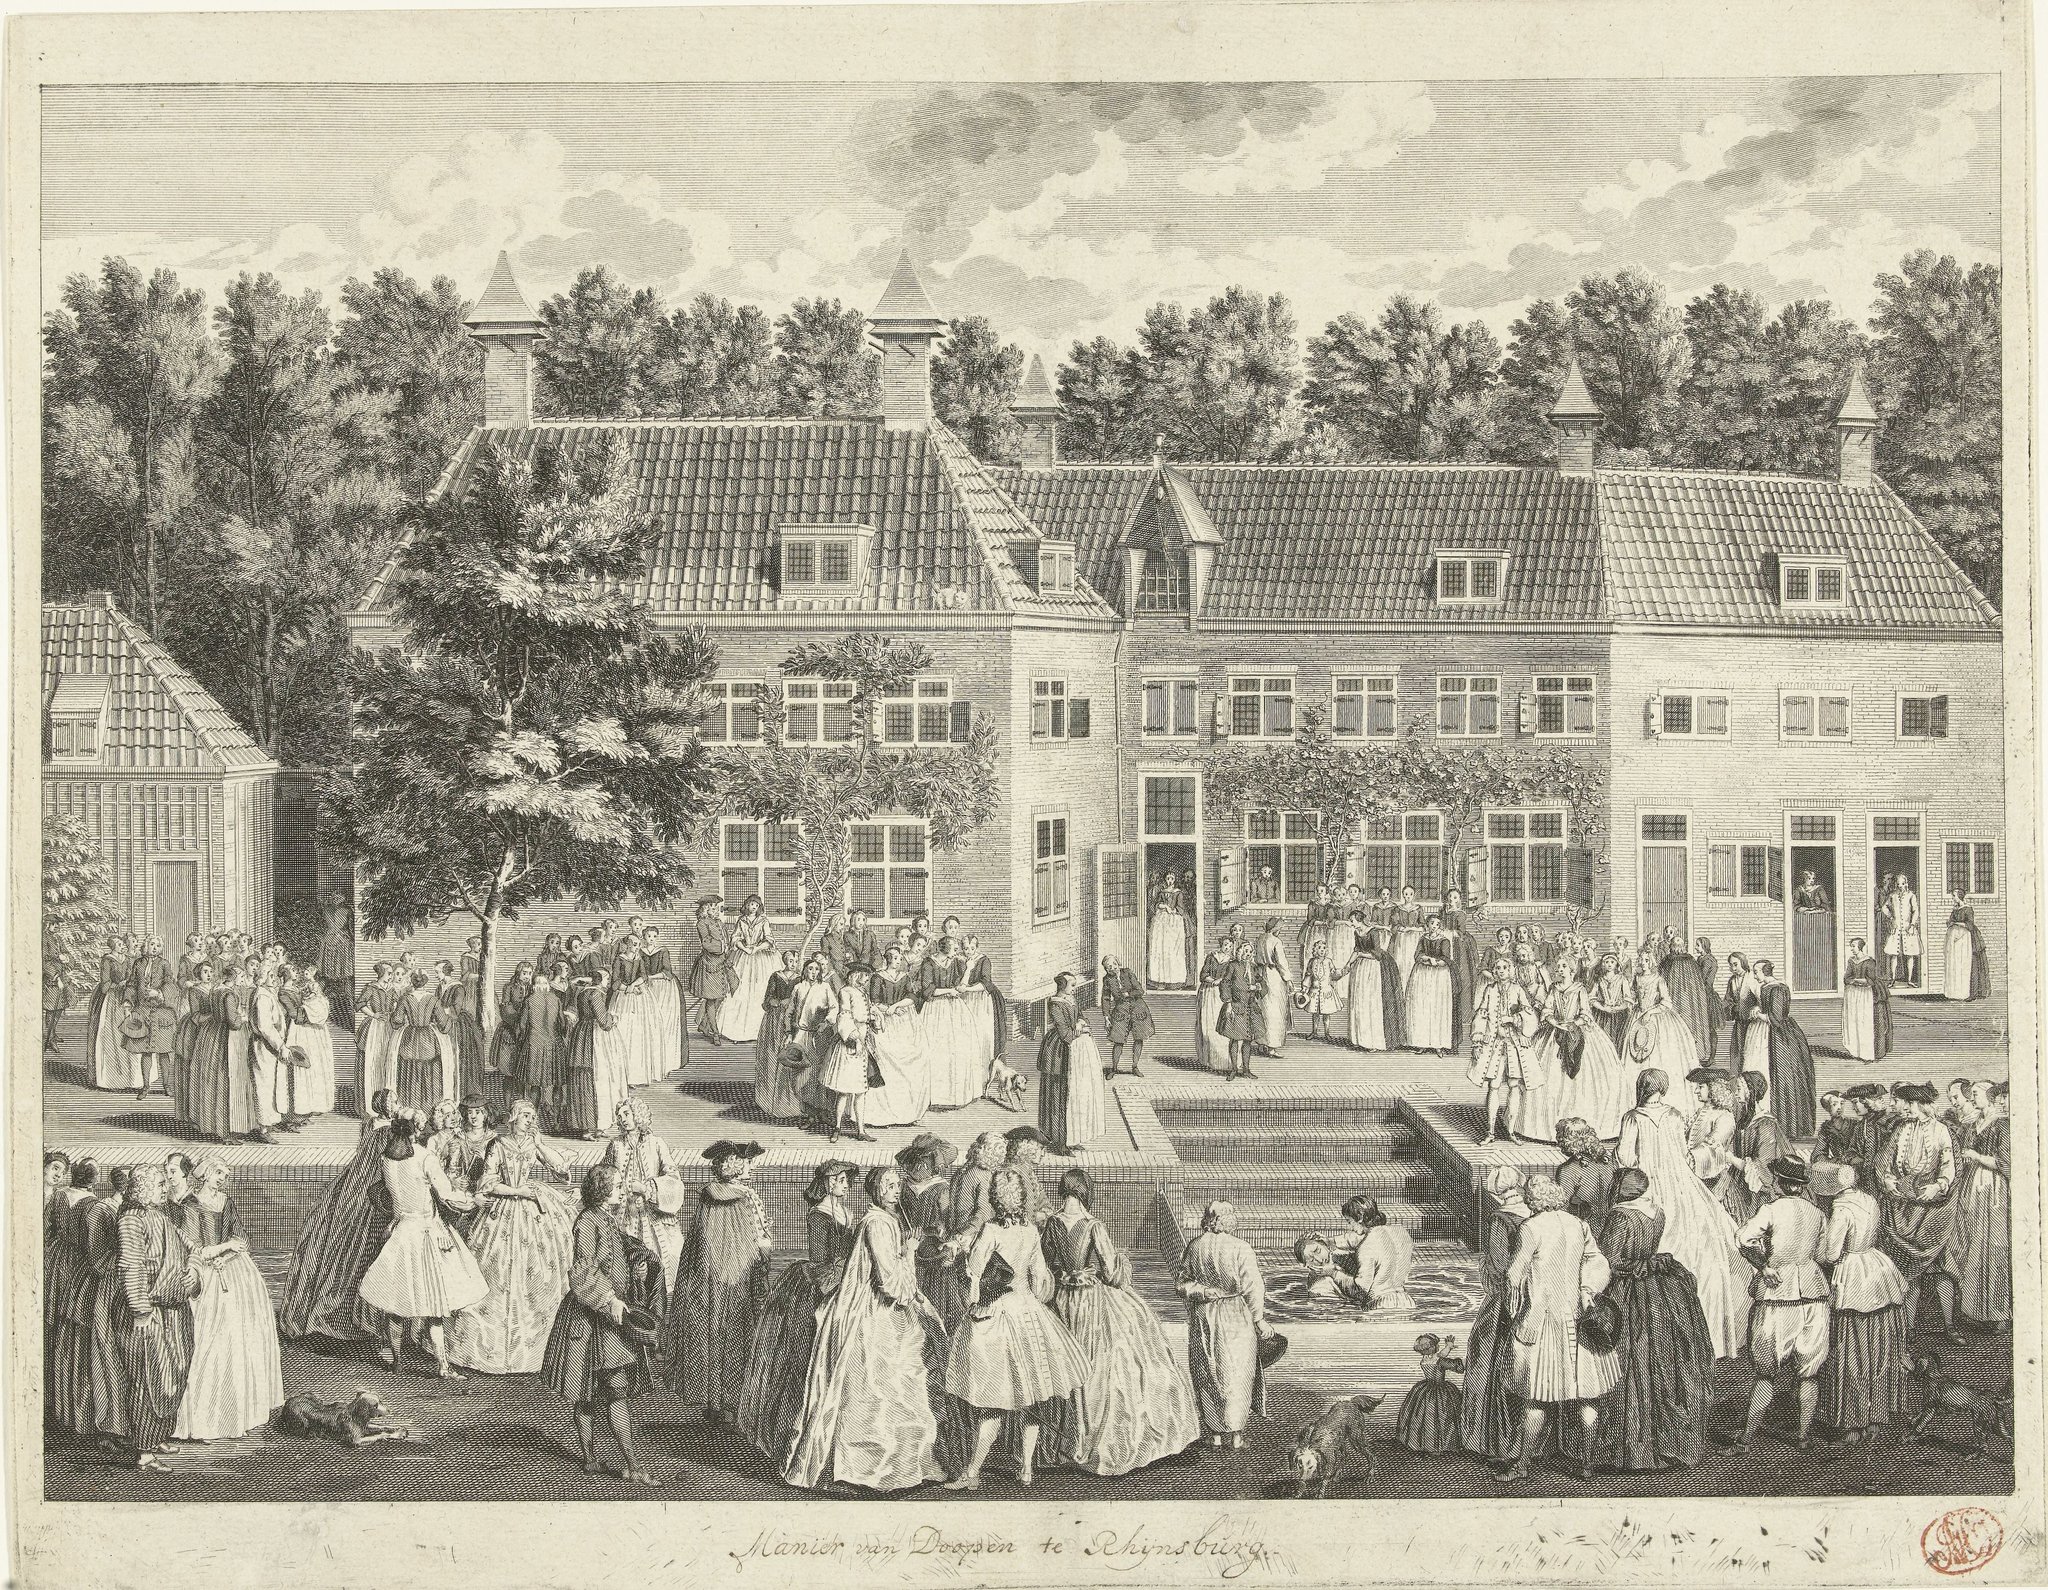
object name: print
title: Doop bij de Rijnsburgse Collegianten, ca. 1735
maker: balthasar bernards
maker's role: print maker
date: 1736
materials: paper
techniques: drypoint, engraving, etching, writing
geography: northern netherlands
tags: baptism ~ protestant service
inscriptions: collector's mark: Lugt 2228, collector's mark: Lugt 195, inscription: ‘Manier van Doopeen te Rhijnsburg’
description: Doopceremonie bij de Rijnsburgse Collegianten, ca. 1735. Doop door onderdompeling van volwassenen in een gracht om het Groot Huis, bijgewoond door de leden van de gemeente. In de marge een opschrift in handschrift en krassen met droge naald.